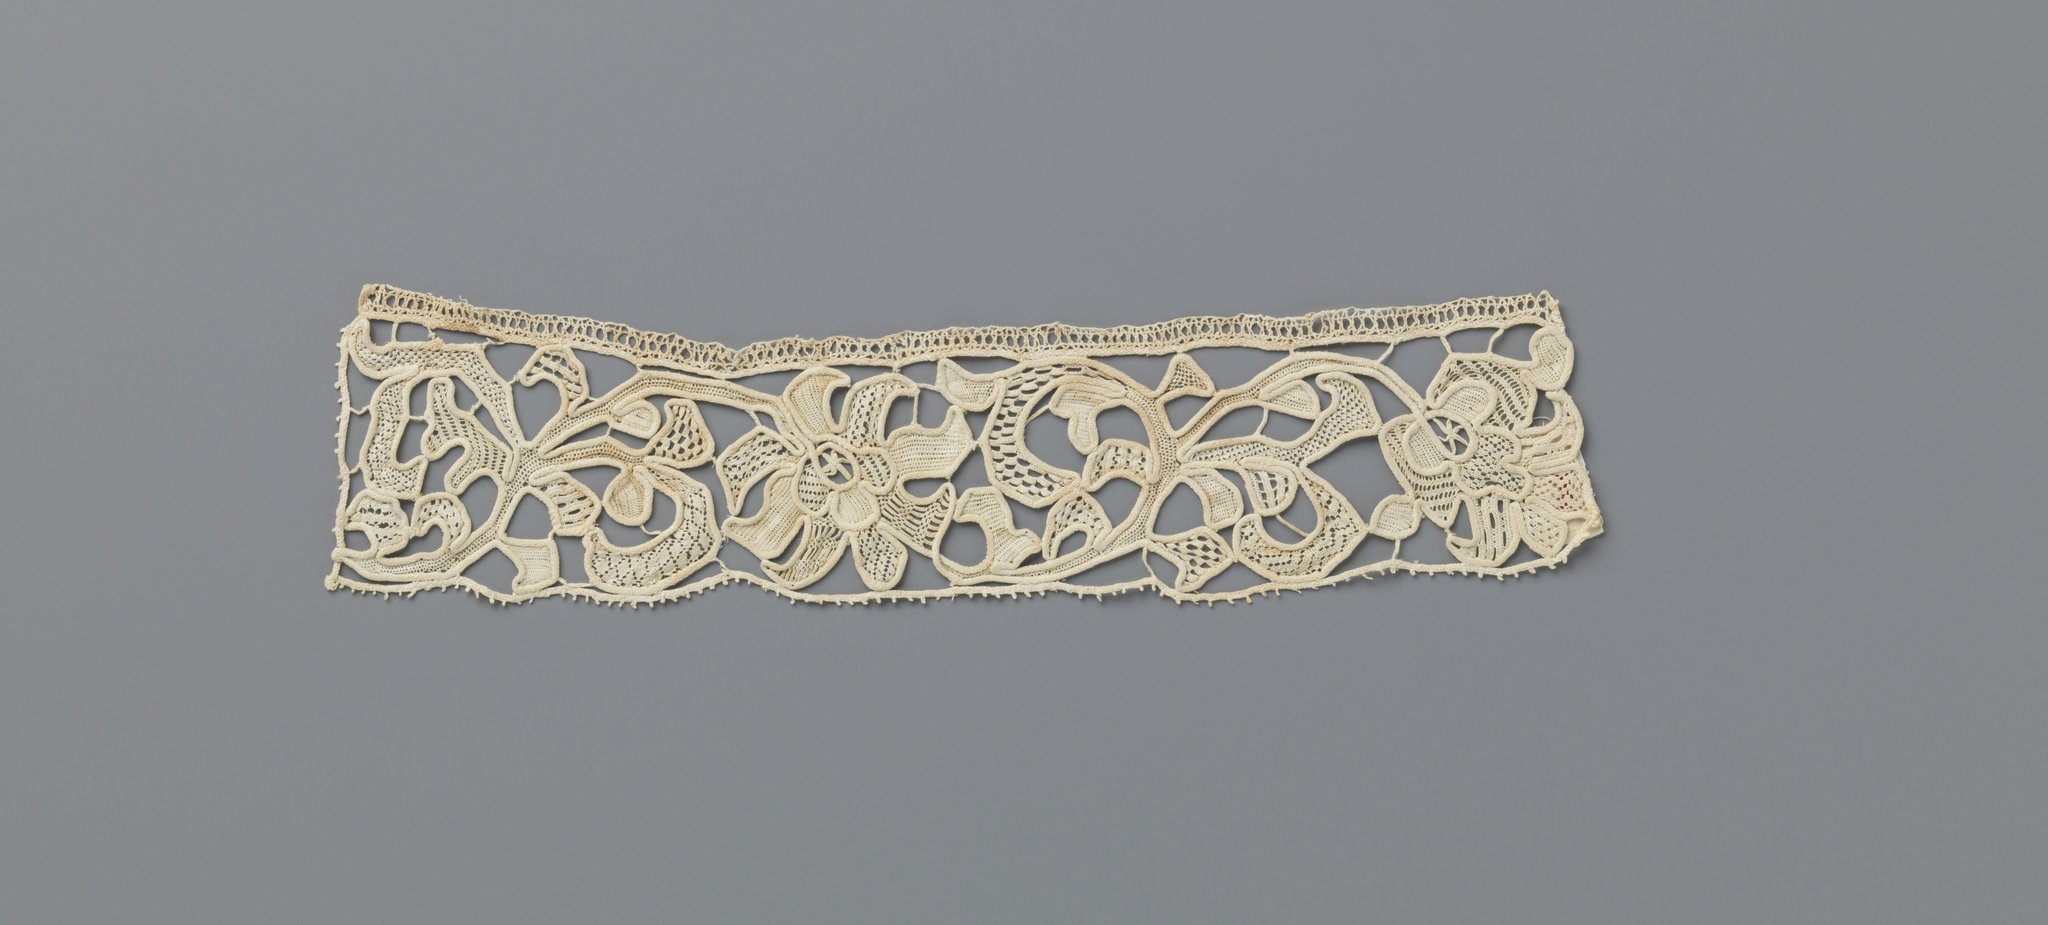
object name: strip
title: Strook naaldkant met lopende rank waaraan twee grillige bloemen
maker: Anonymous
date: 1800-1899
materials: cotton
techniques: needle lace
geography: venice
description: Strook naturelkleurig naaldkant. Patroon van een lopende rank waaraan twee grillige bloemen en enkele bladeren. De patroondelen worden op een enkele plaats door een spijl aan elkaar verbonden. De contouren van het patroon worden gevormd door een ronde gekloste veter. Binnen de contouren en ook binnen de afzonderlijke bloemen verschillende siergronden door uitsparingen in het volwerk. Volwerk met gedraaide festonsteken. De bovenzijde is afgezet met een rand kloskant. De onderzijde en linkerzijde zijn afgewerkt met een rechte picotrand.